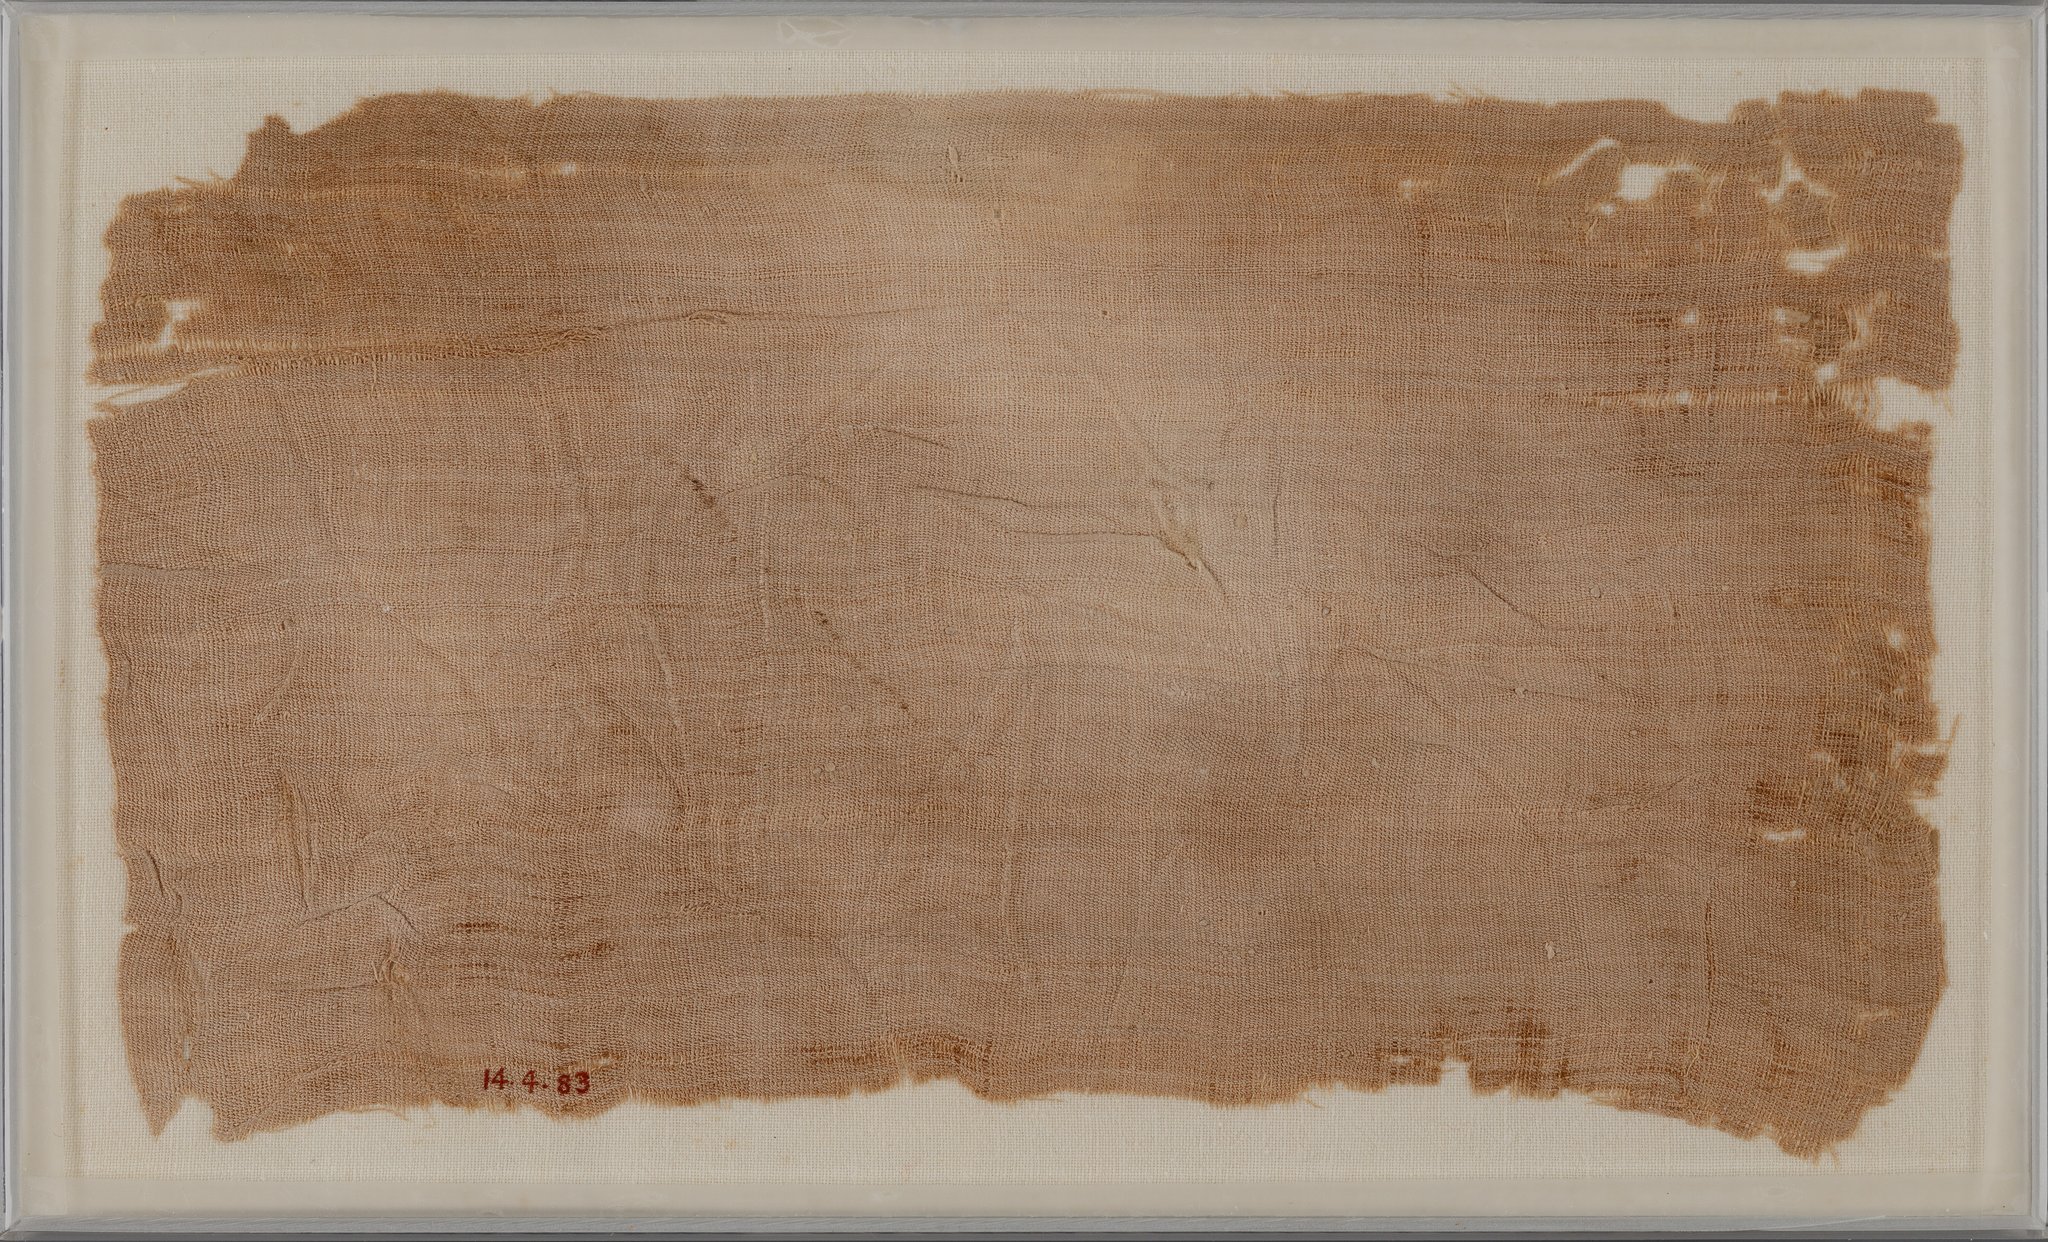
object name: linen fragment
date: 2880-2465 BCE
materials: linen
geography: egypt